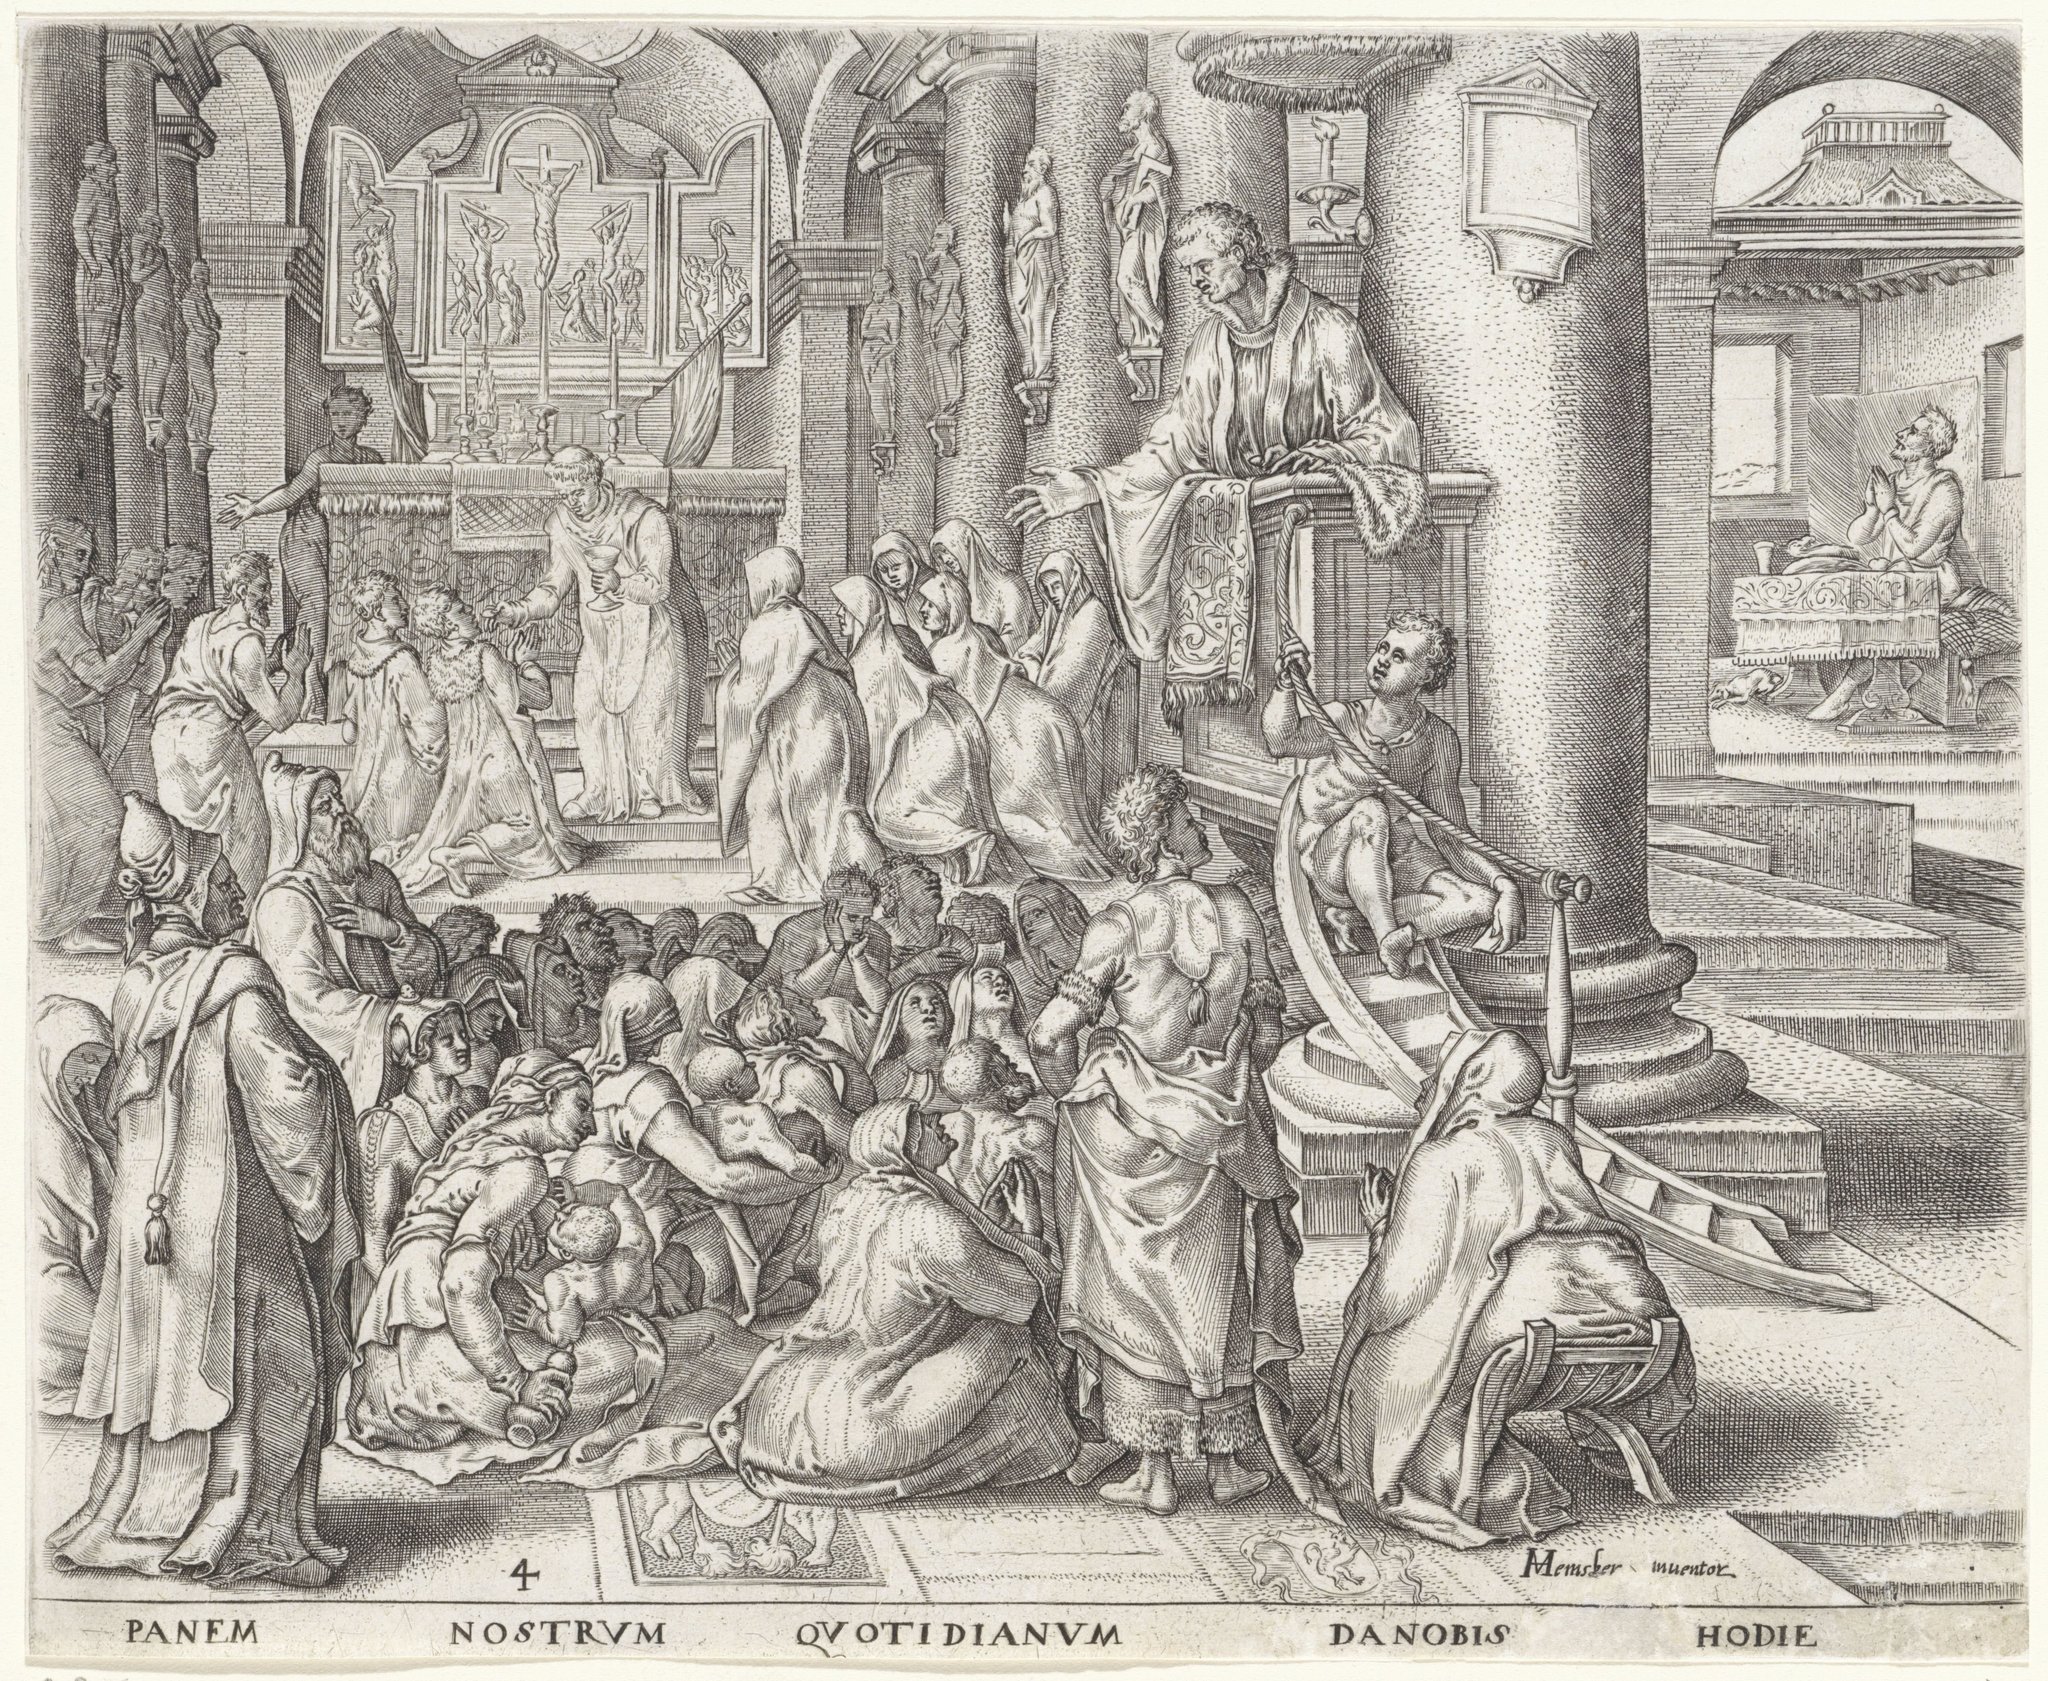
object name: print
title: Geef ons vandaag het brood dat wij nodig hebben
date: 1569-1573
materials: paper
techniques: engraving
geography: antwerp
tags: 'give us this day our daily bread' ~ the lord's prayer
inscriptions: collector's mark: Lugt 2228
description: Mannen en vrouwen zitten in de kerk op de vloer en luisteren naar een preek van de priester. Op de achtergrond bij het altaar deelt een priester de hosti uit aan geknielde gelovigen. Rechts in een vertrek bidt een man. Het Latijnse onderschrift is een deel uit het gebed het Onze Vader.